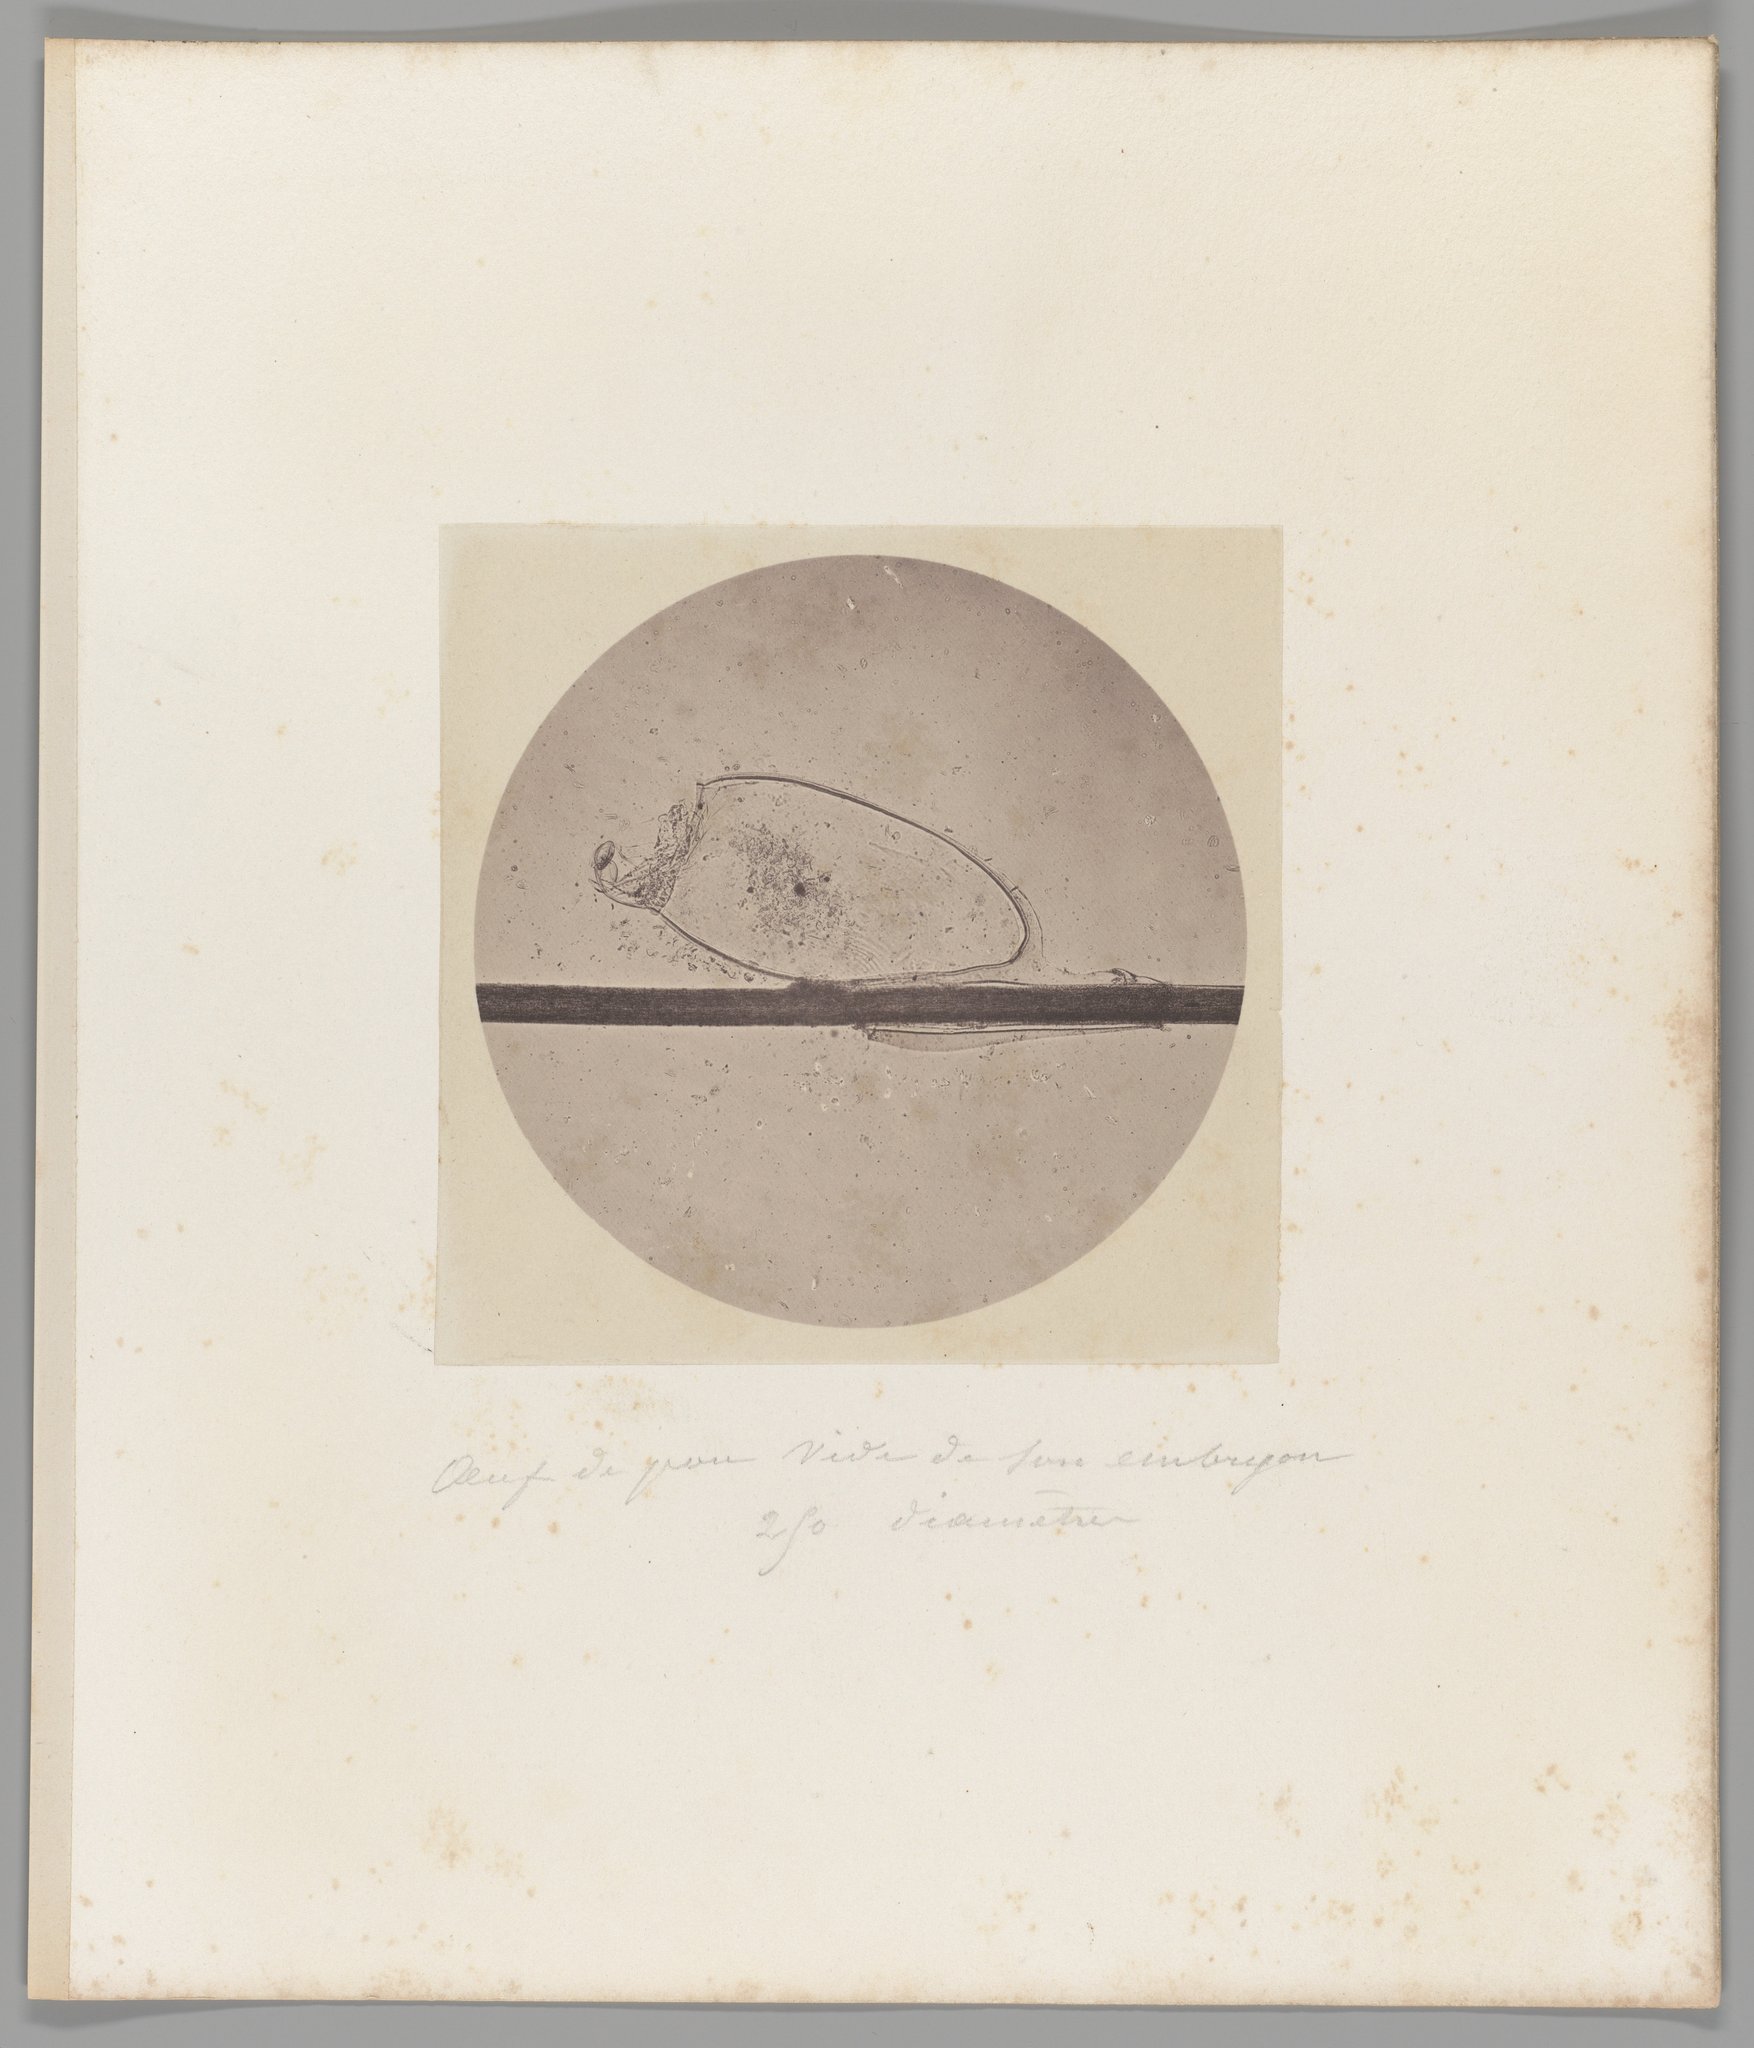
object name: photograph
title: [Untitled]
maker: auguste-adolphe bertsch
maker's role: artist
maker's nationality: french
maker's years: 1813-1871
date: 1853-1857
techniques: salted paper print